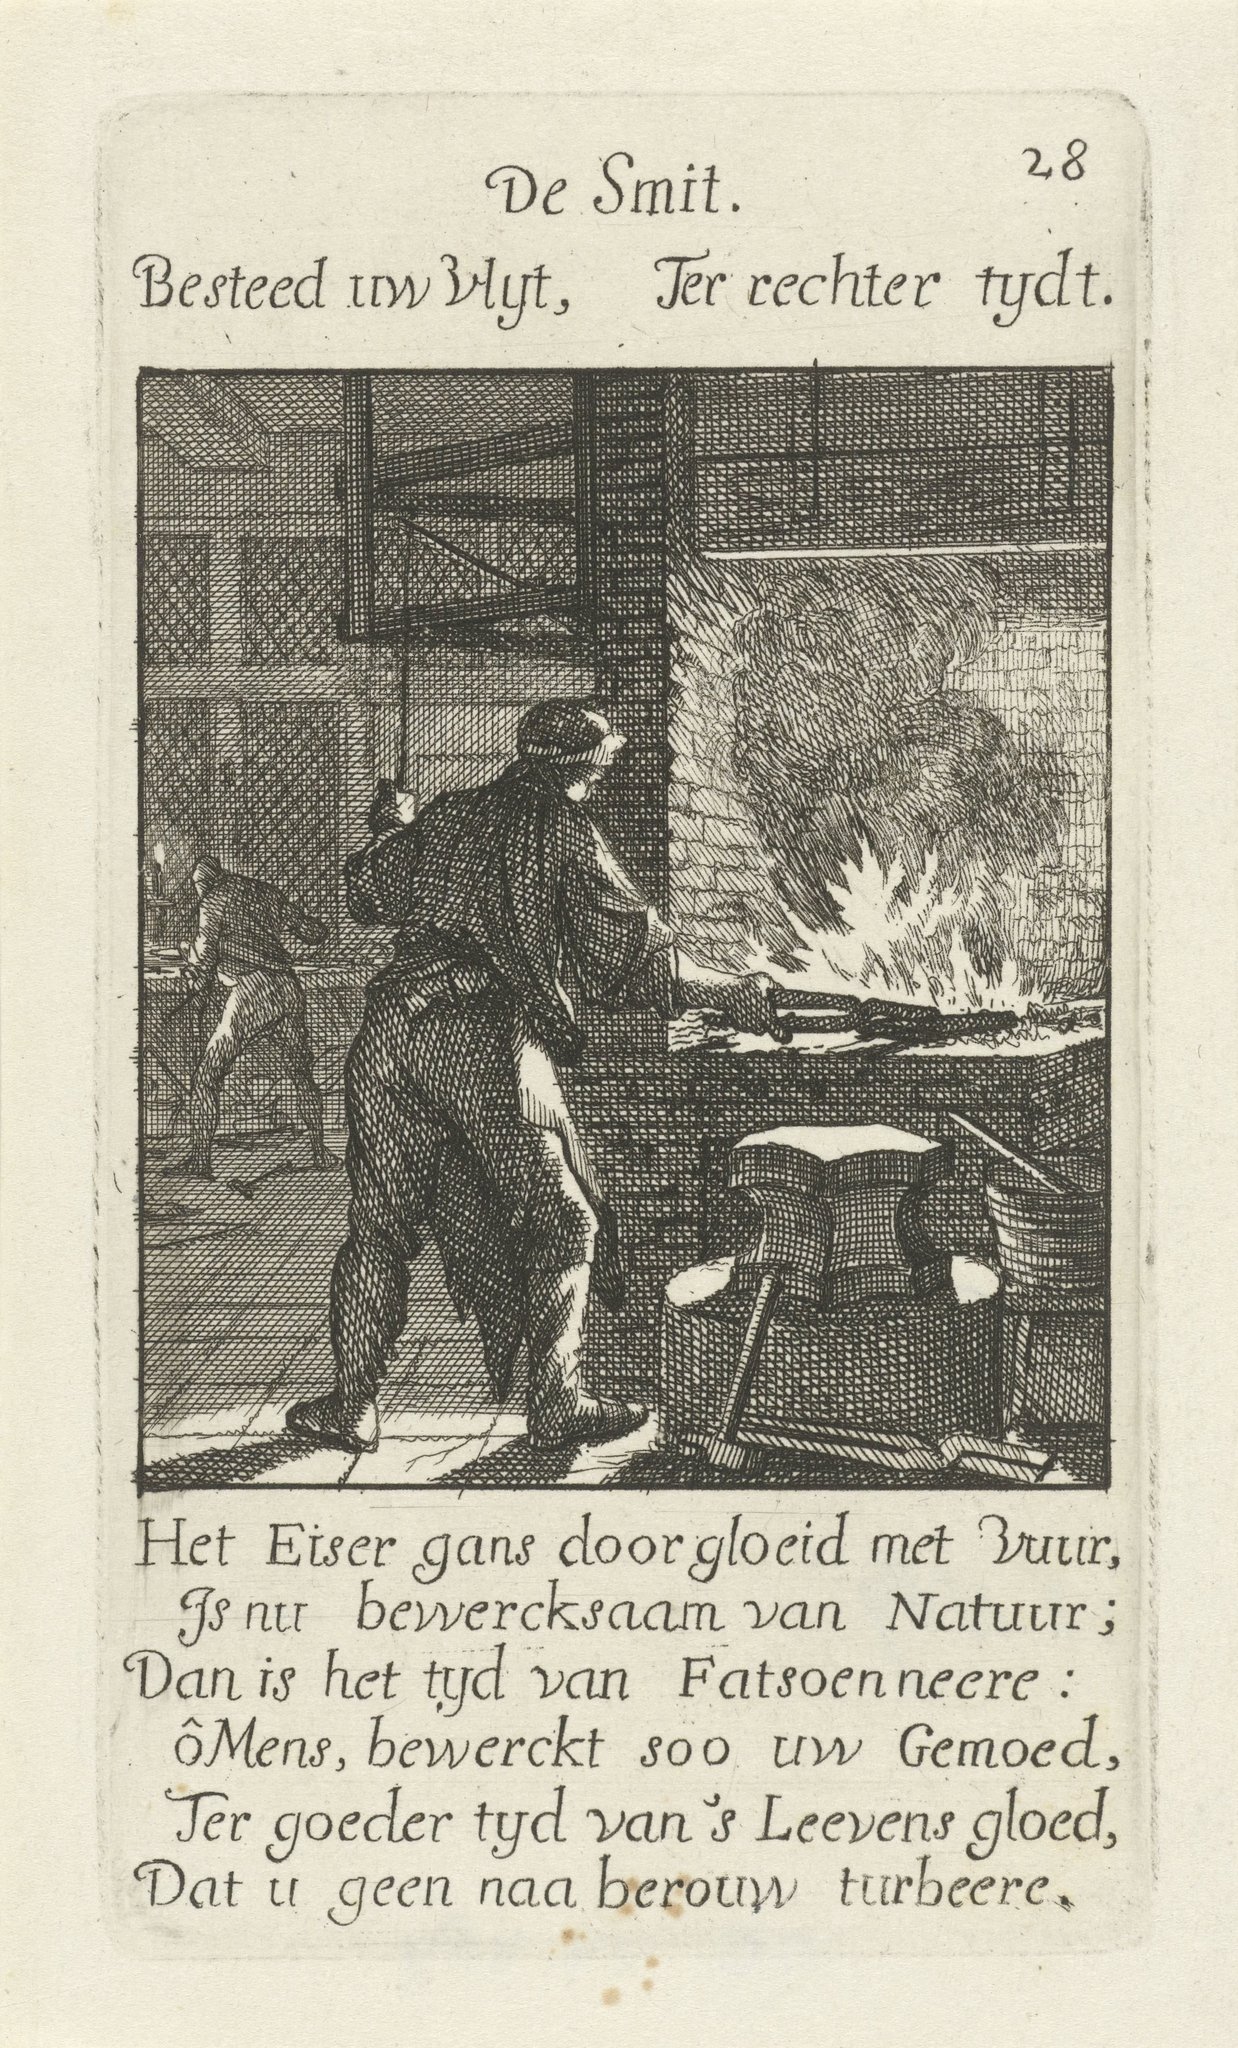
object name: print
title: Het Menselyk Bedryf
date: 1694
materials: paper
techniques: etching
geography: amsterdam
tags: handicrafts, craftsman at work, smith, blacksmith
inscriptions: collector's mark: Lugt 2228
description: Maakt deel uit van de 100-delige serie beroepsprenten van Jan en Caspar Luyken, getiteld: Het menselyk bedryf. S.l.s.n., 1694 (eerste druk).